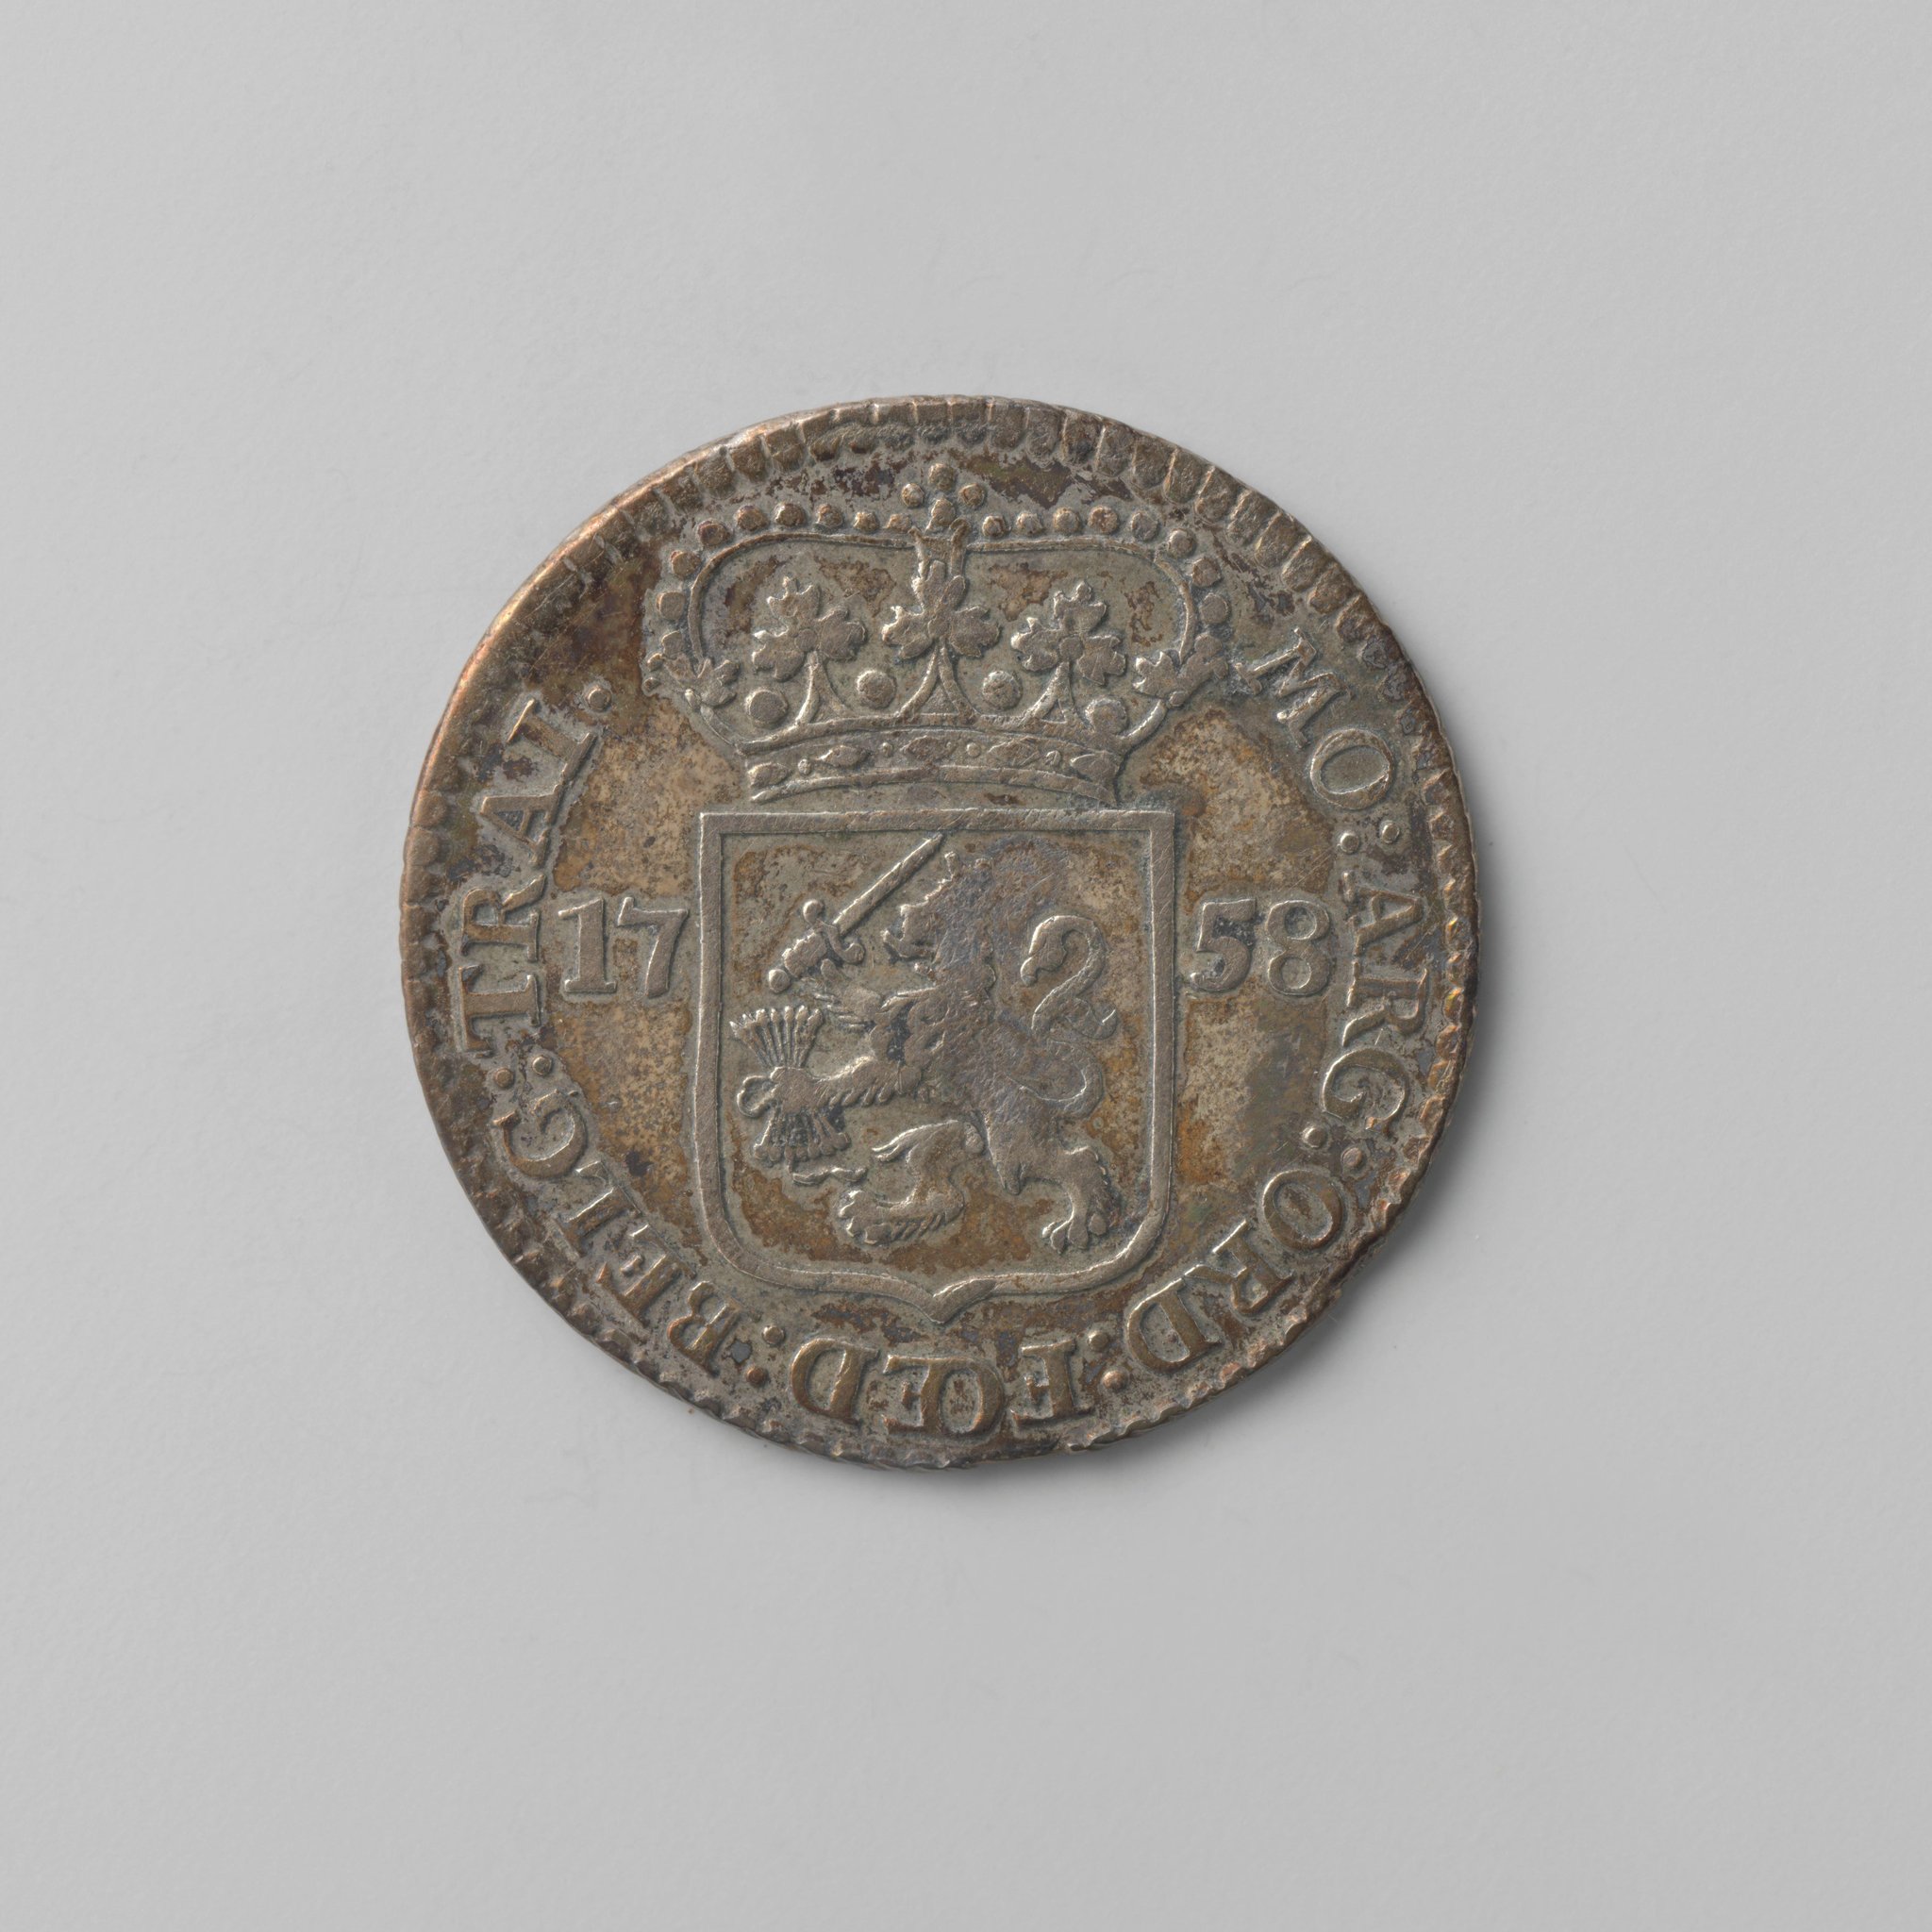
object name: coin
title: Utrecht, kwart gulden, 1758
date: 1758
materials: silver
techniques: striking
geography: utrecht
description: Voorzijde: tussen jaartal gekroond generaliteirtswapenschild. Keerzijde: Nederlandse maagd met vrijheidshoed en speer, leunend op een bijbel op een altaar. Kabelrand. Zogenaamde muntmeesterspenning.